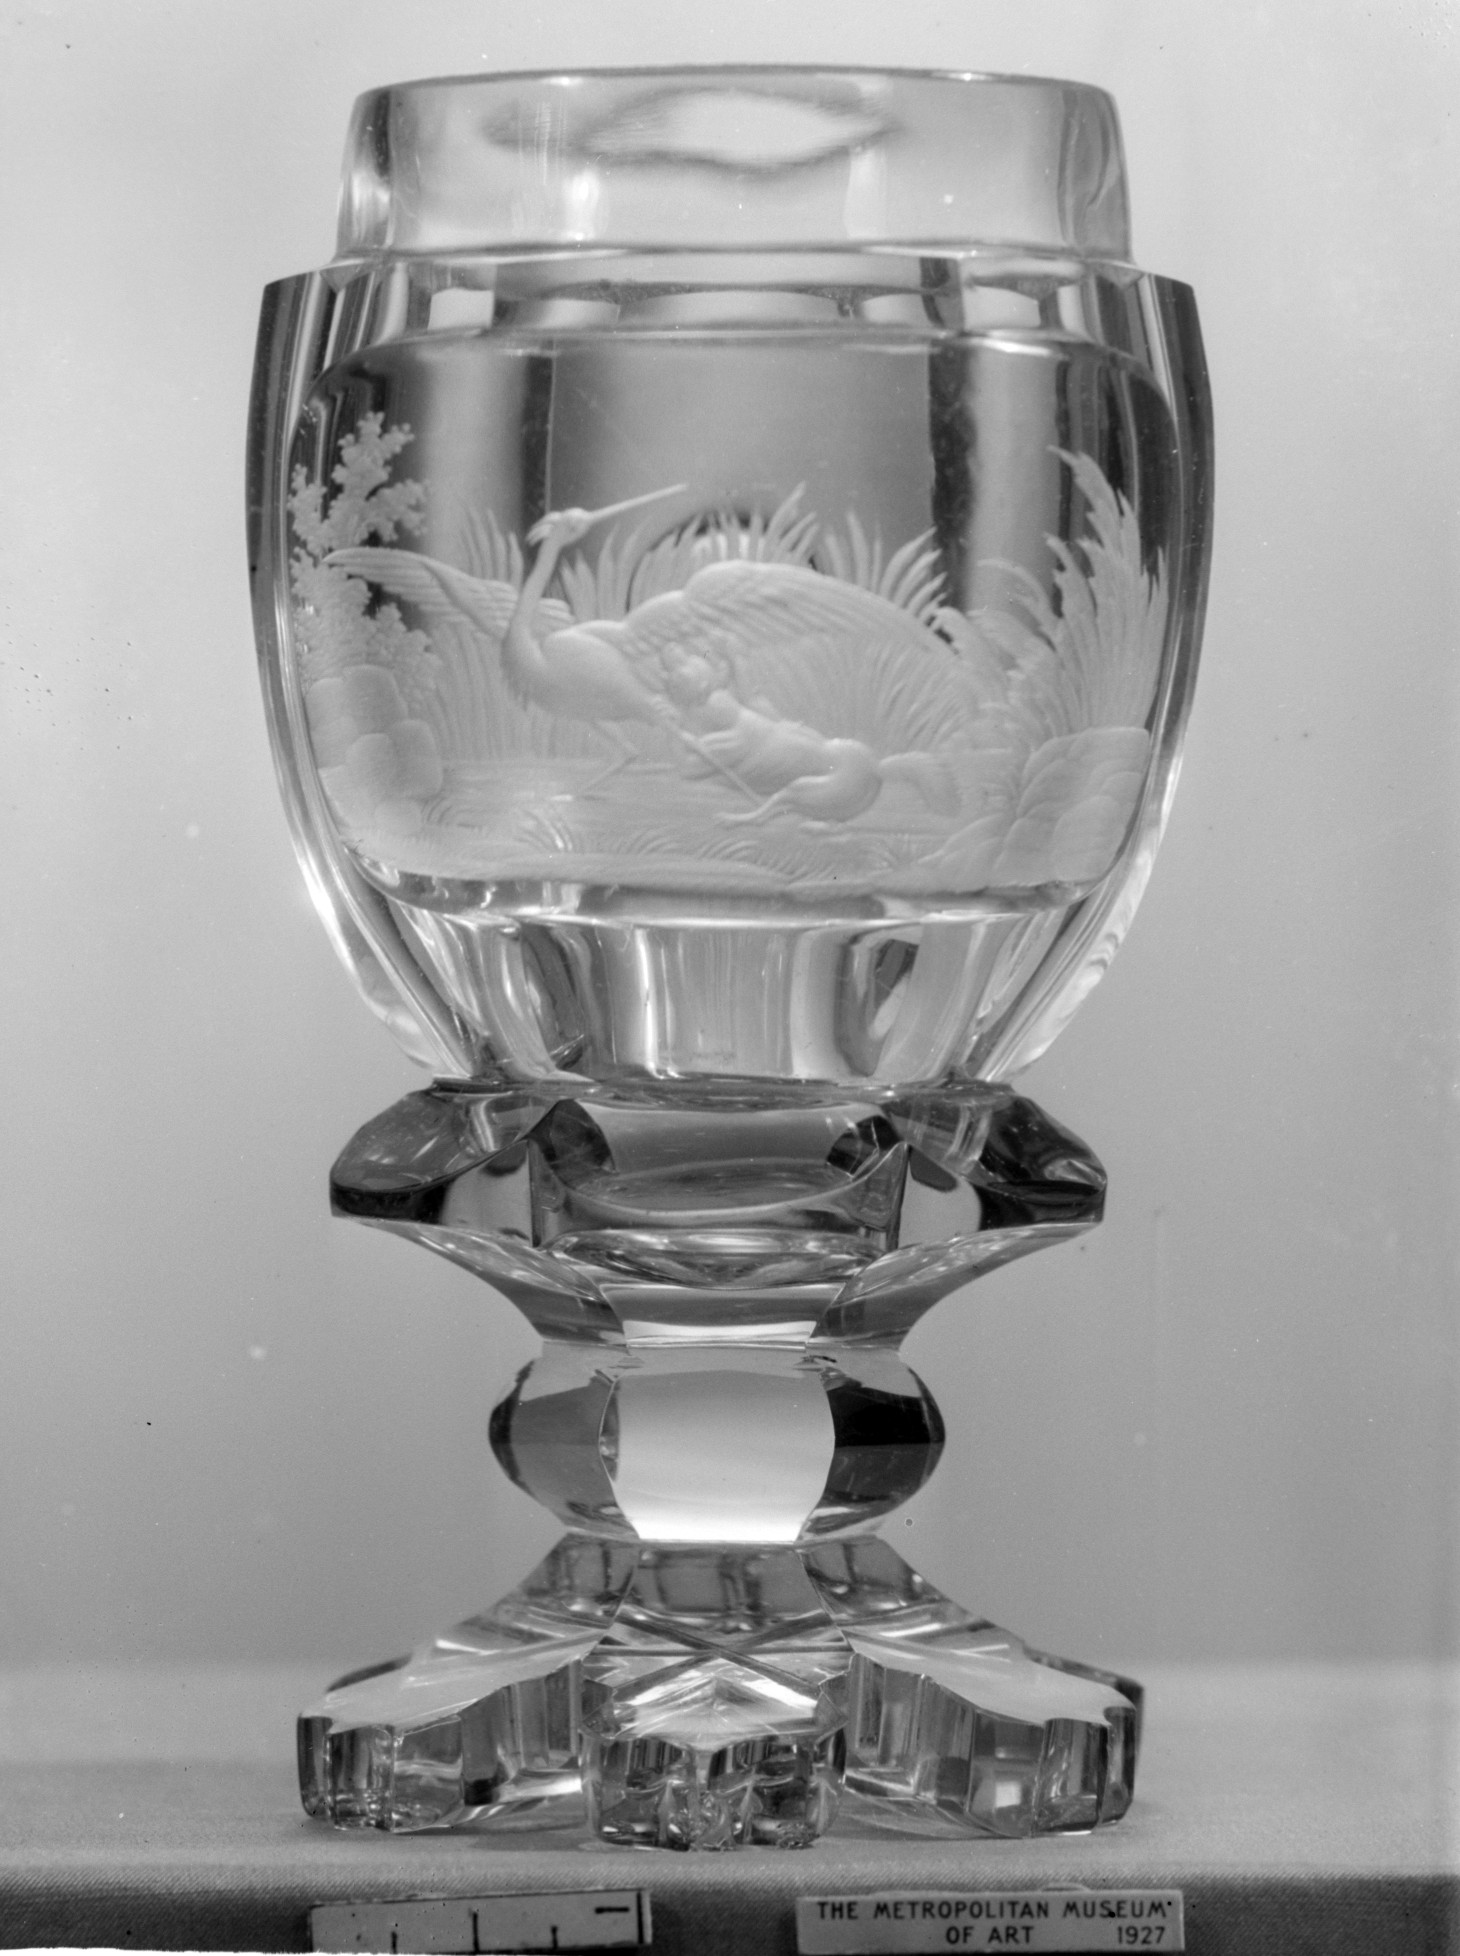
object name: goblet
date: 1830-1840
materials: glass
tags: animals,cranes